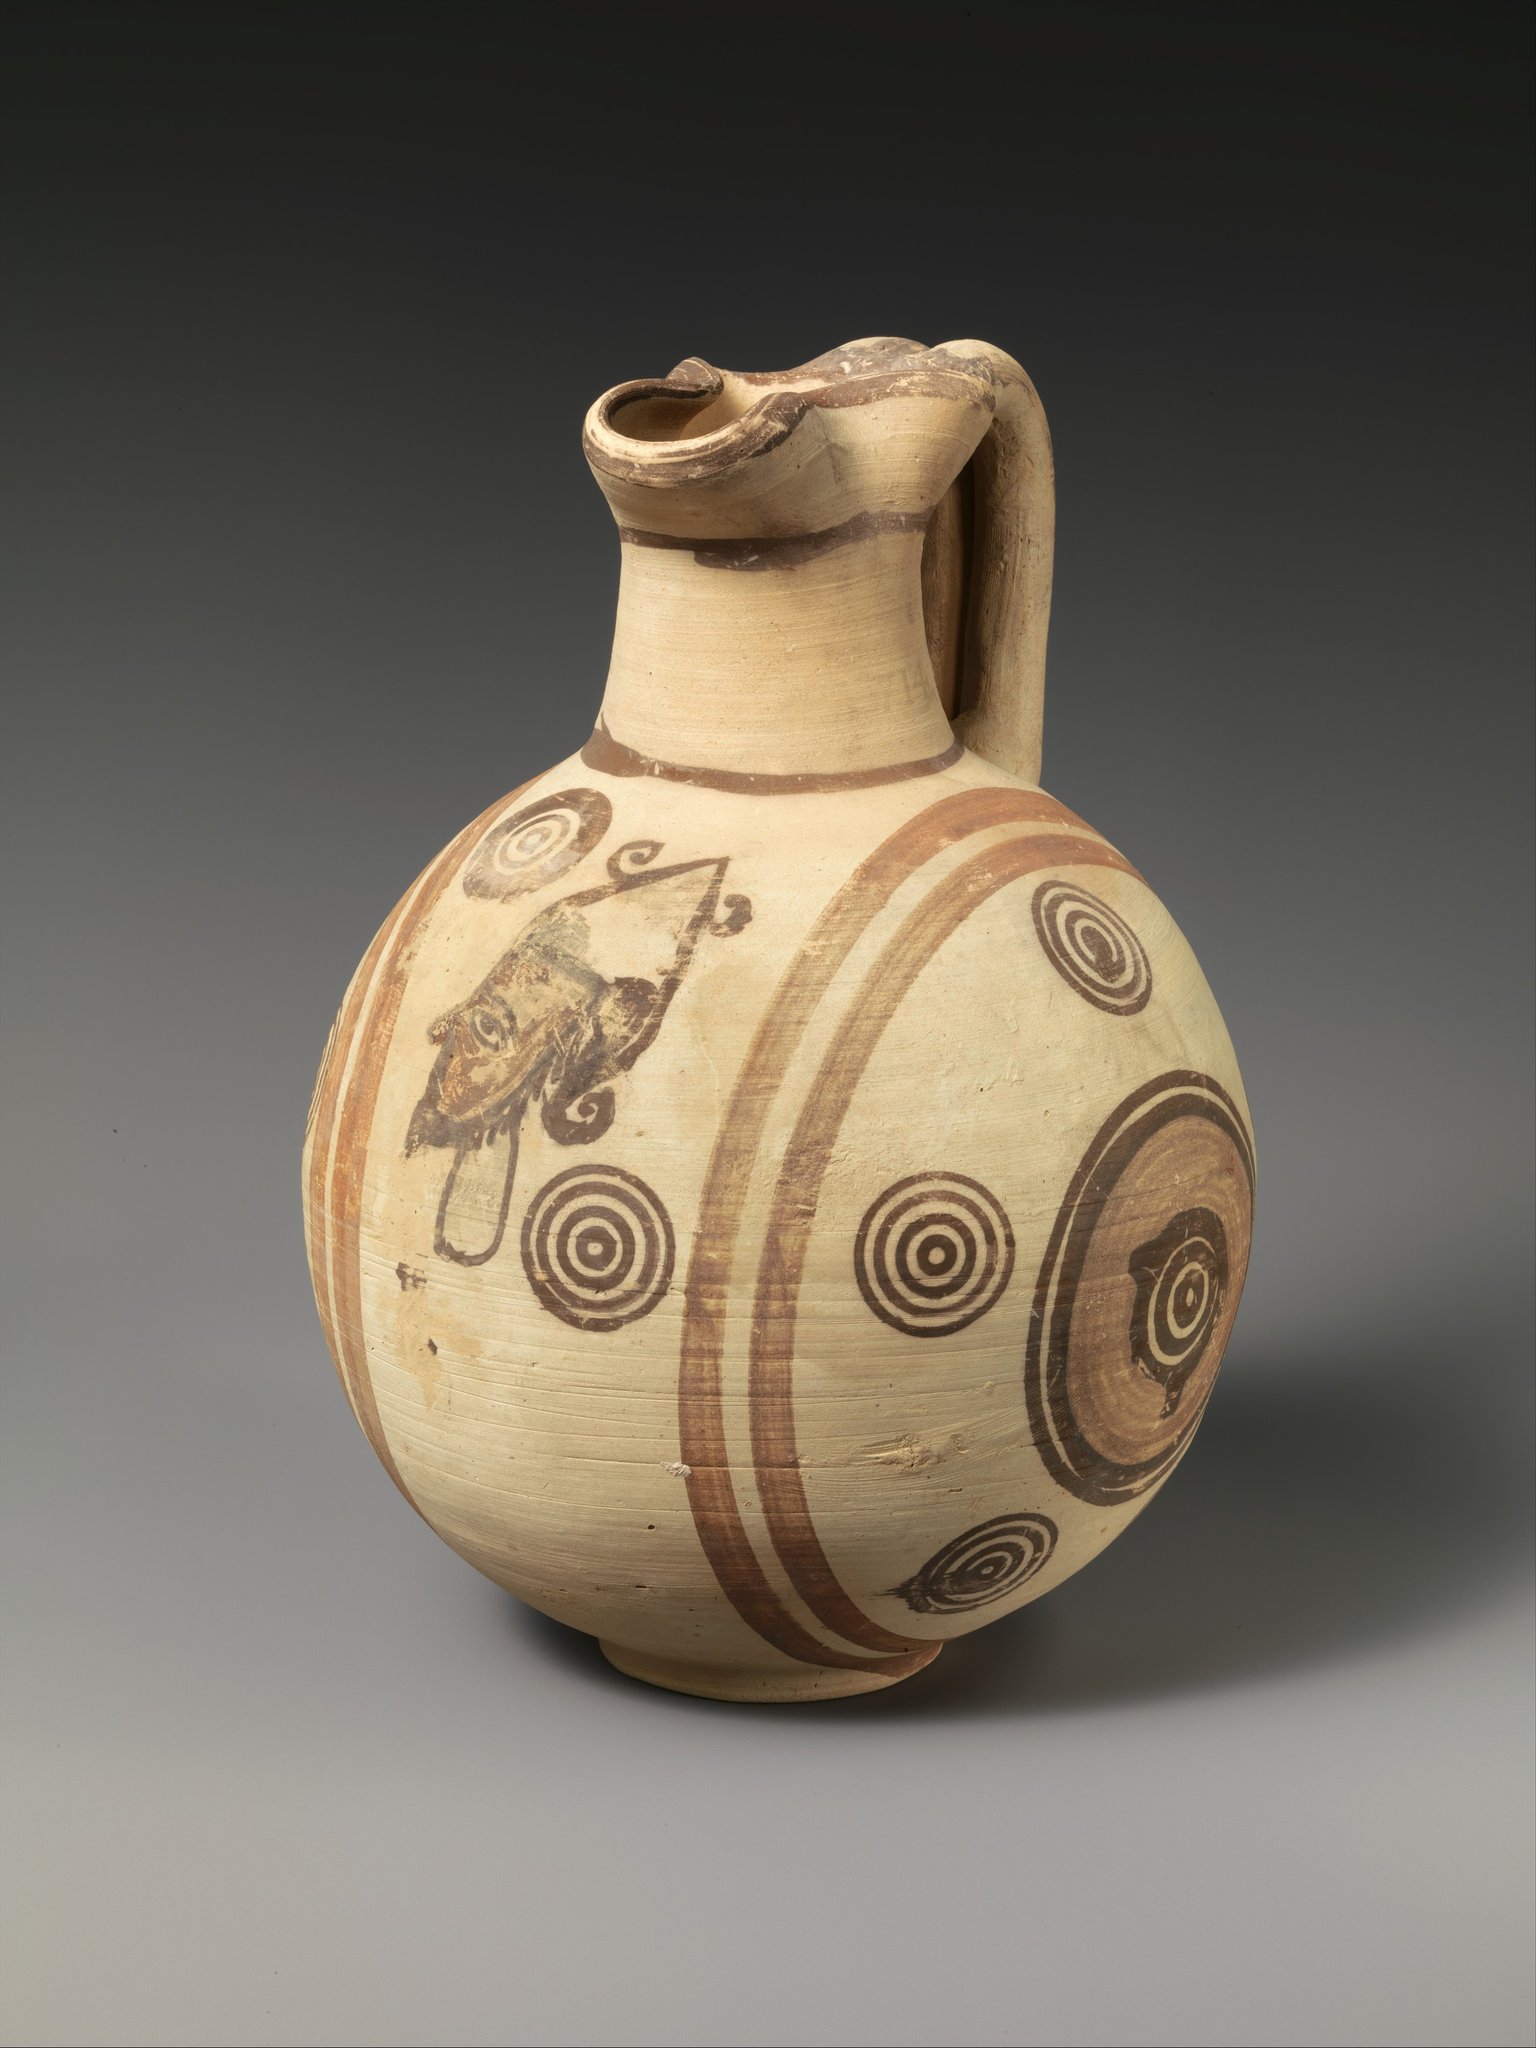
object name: jug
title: Terracotta jug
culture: cypriot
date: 750-600 BCE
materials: terracotta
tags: faces,men